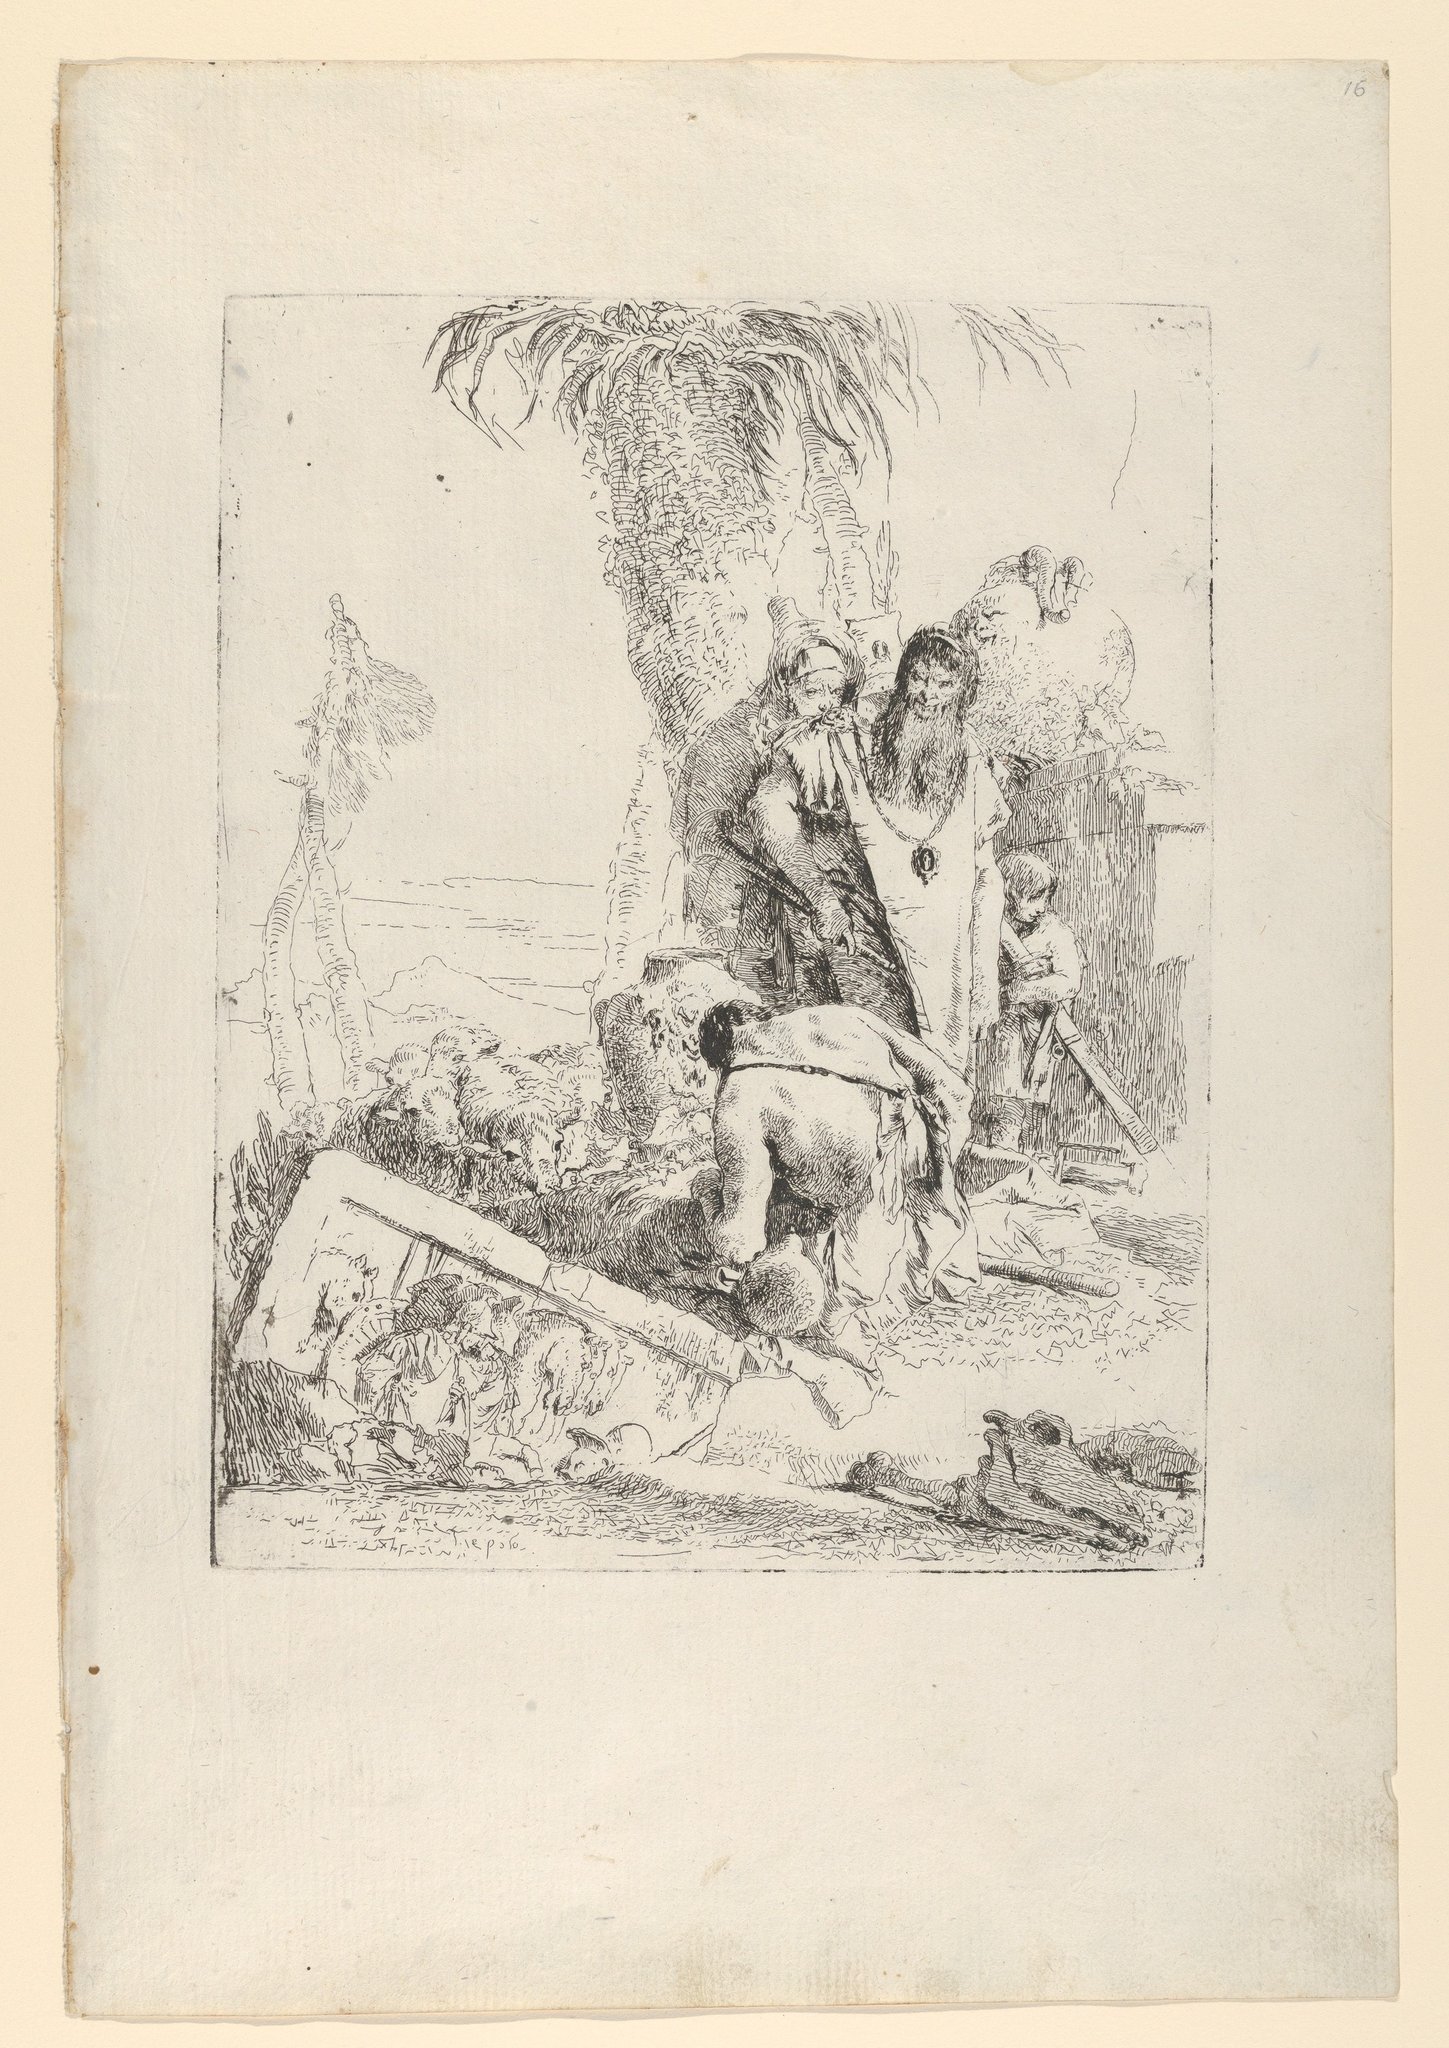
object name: print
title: A Shepherd with two Magicians, from the Scherzi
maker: giovanni battista tiepolo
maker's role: artist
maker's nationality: italian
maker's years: 1696-1770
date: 1740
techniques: etching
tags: magicians,shepherds